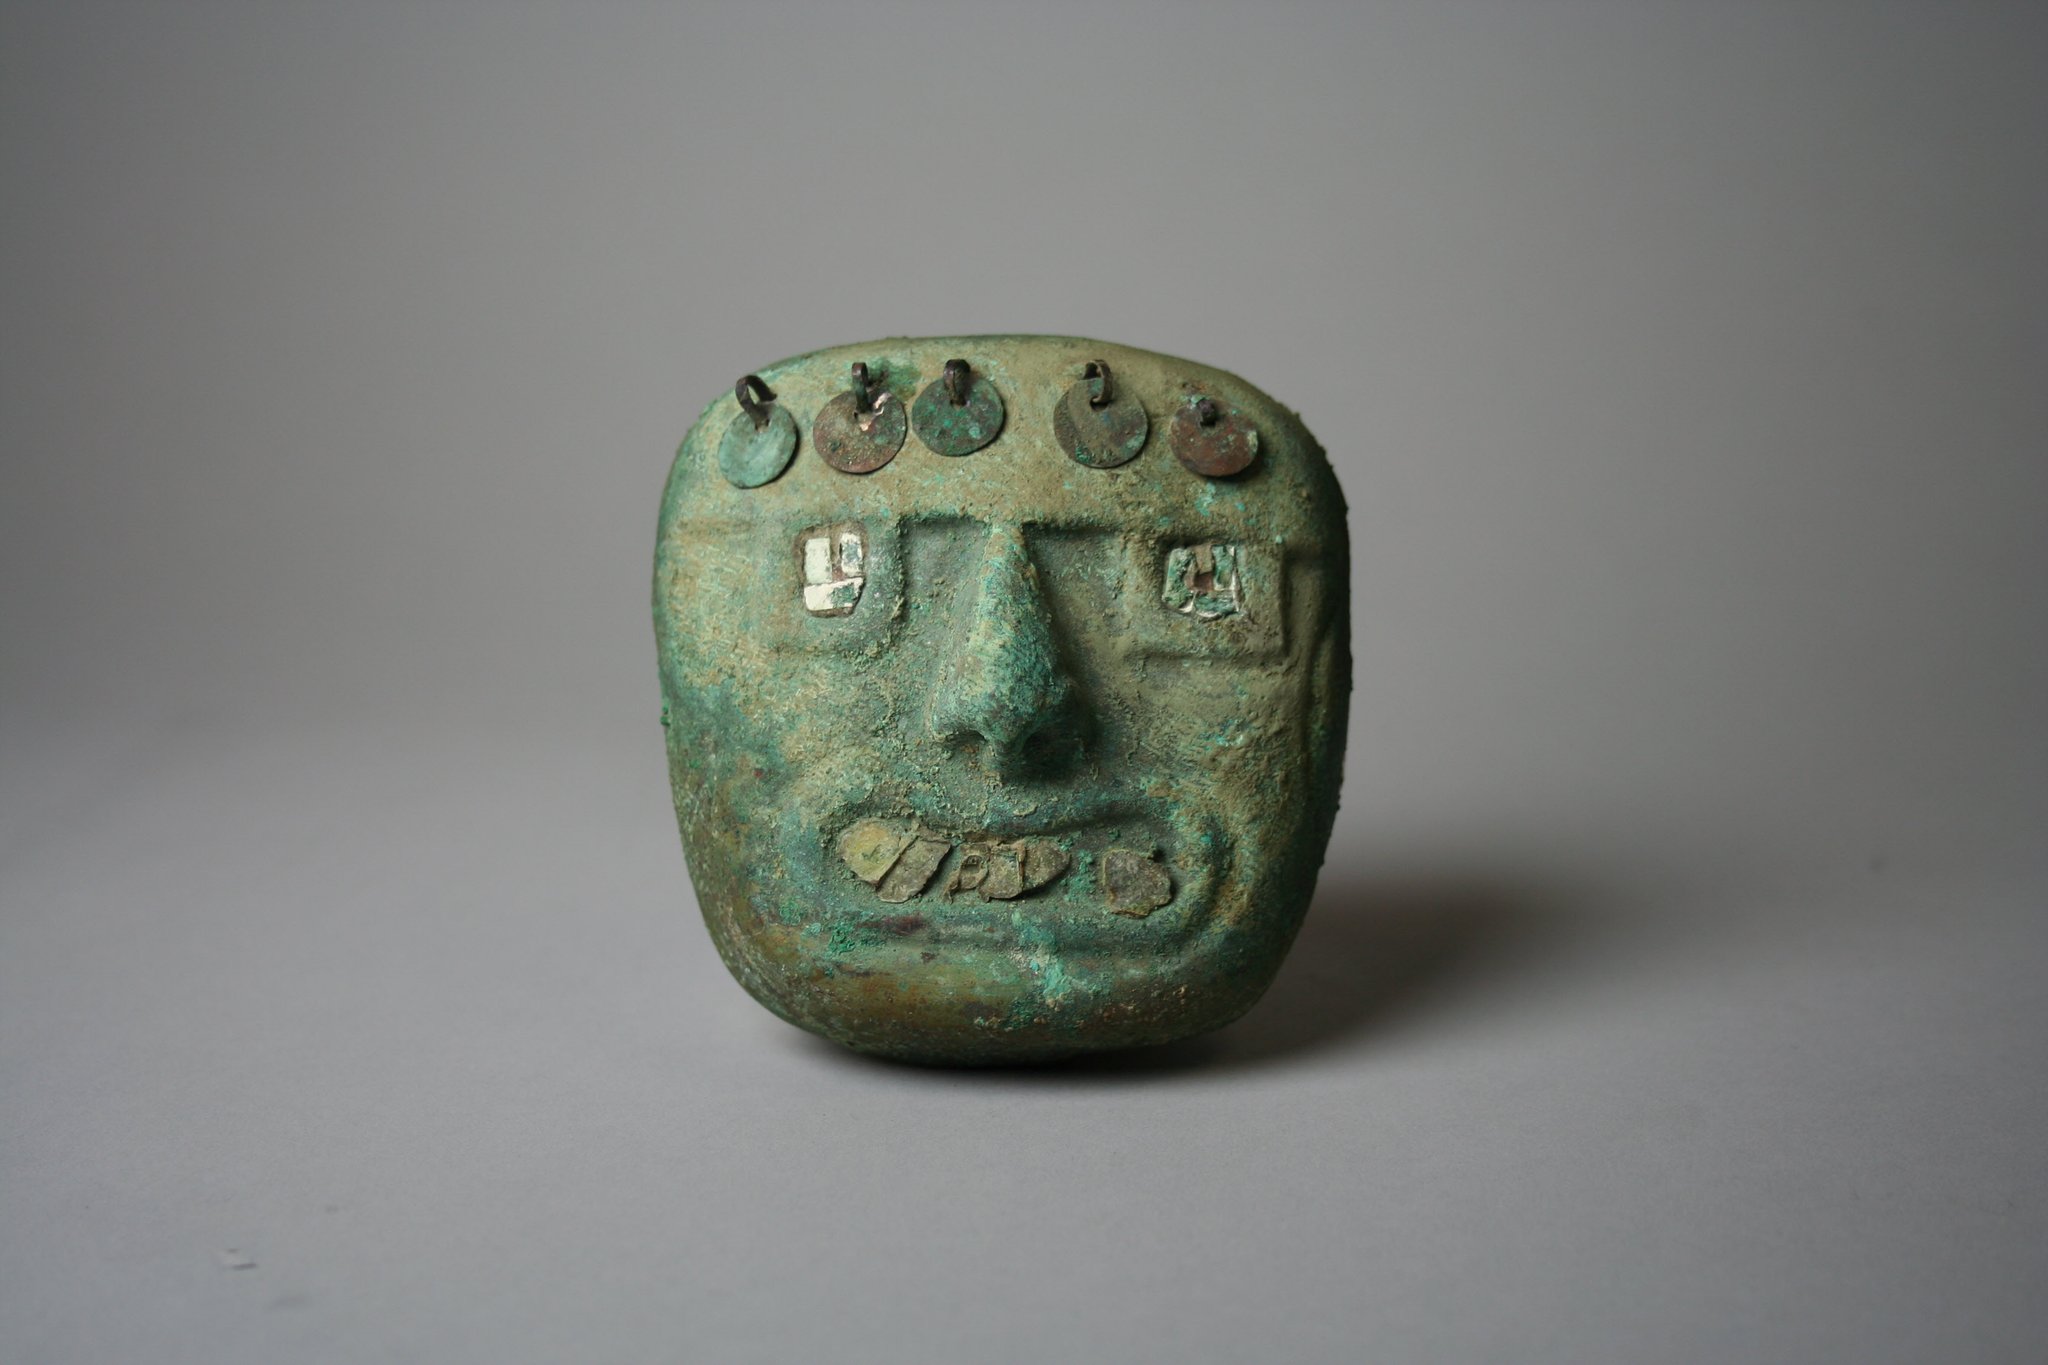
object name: ornament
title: Face Mask Ornament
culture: moche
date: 501-700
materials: gilt copper, shell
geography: peru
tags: faces